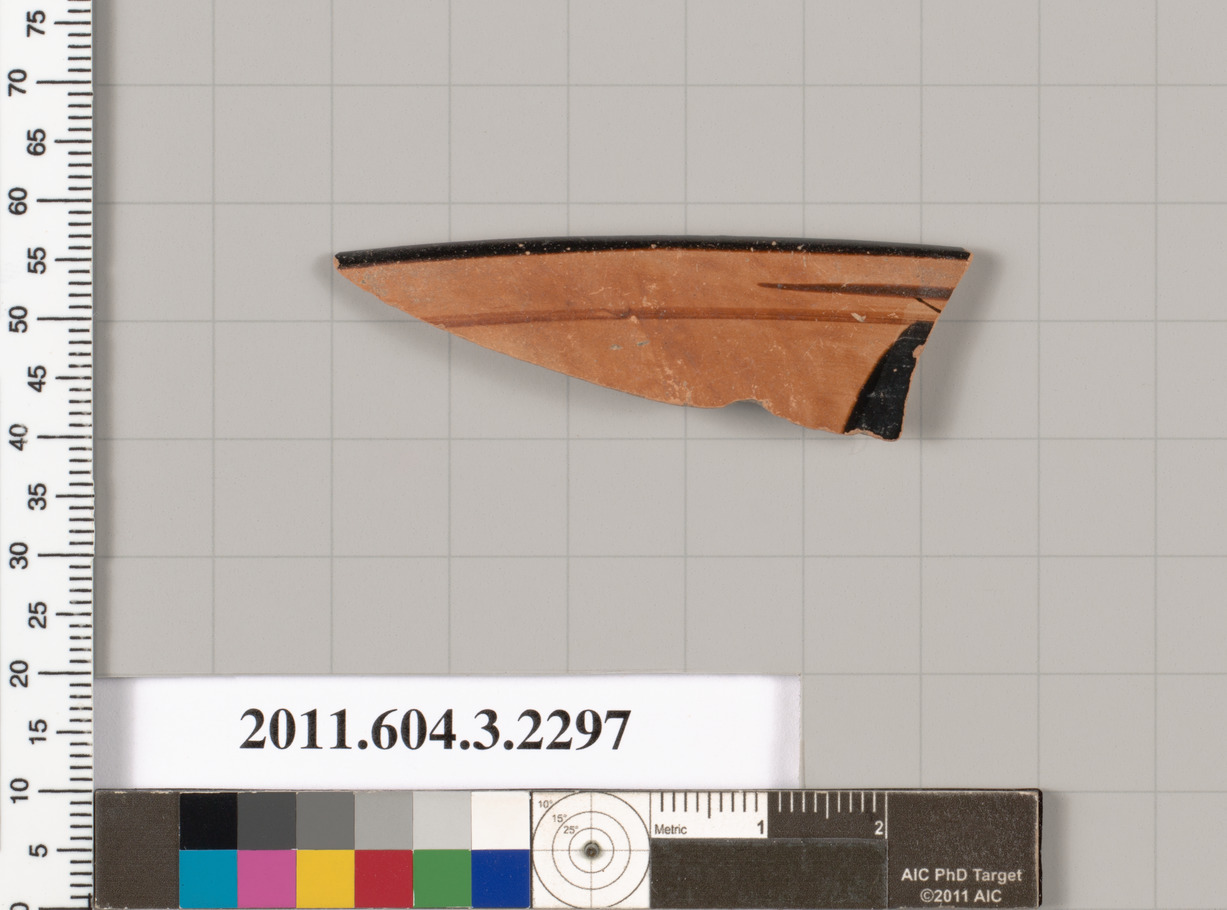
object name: kylix fragment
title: Terracotta rim fragment of a kylix: eye-cup (drinking cup)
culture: greek, attic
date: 530-500 BCE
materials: terracotta